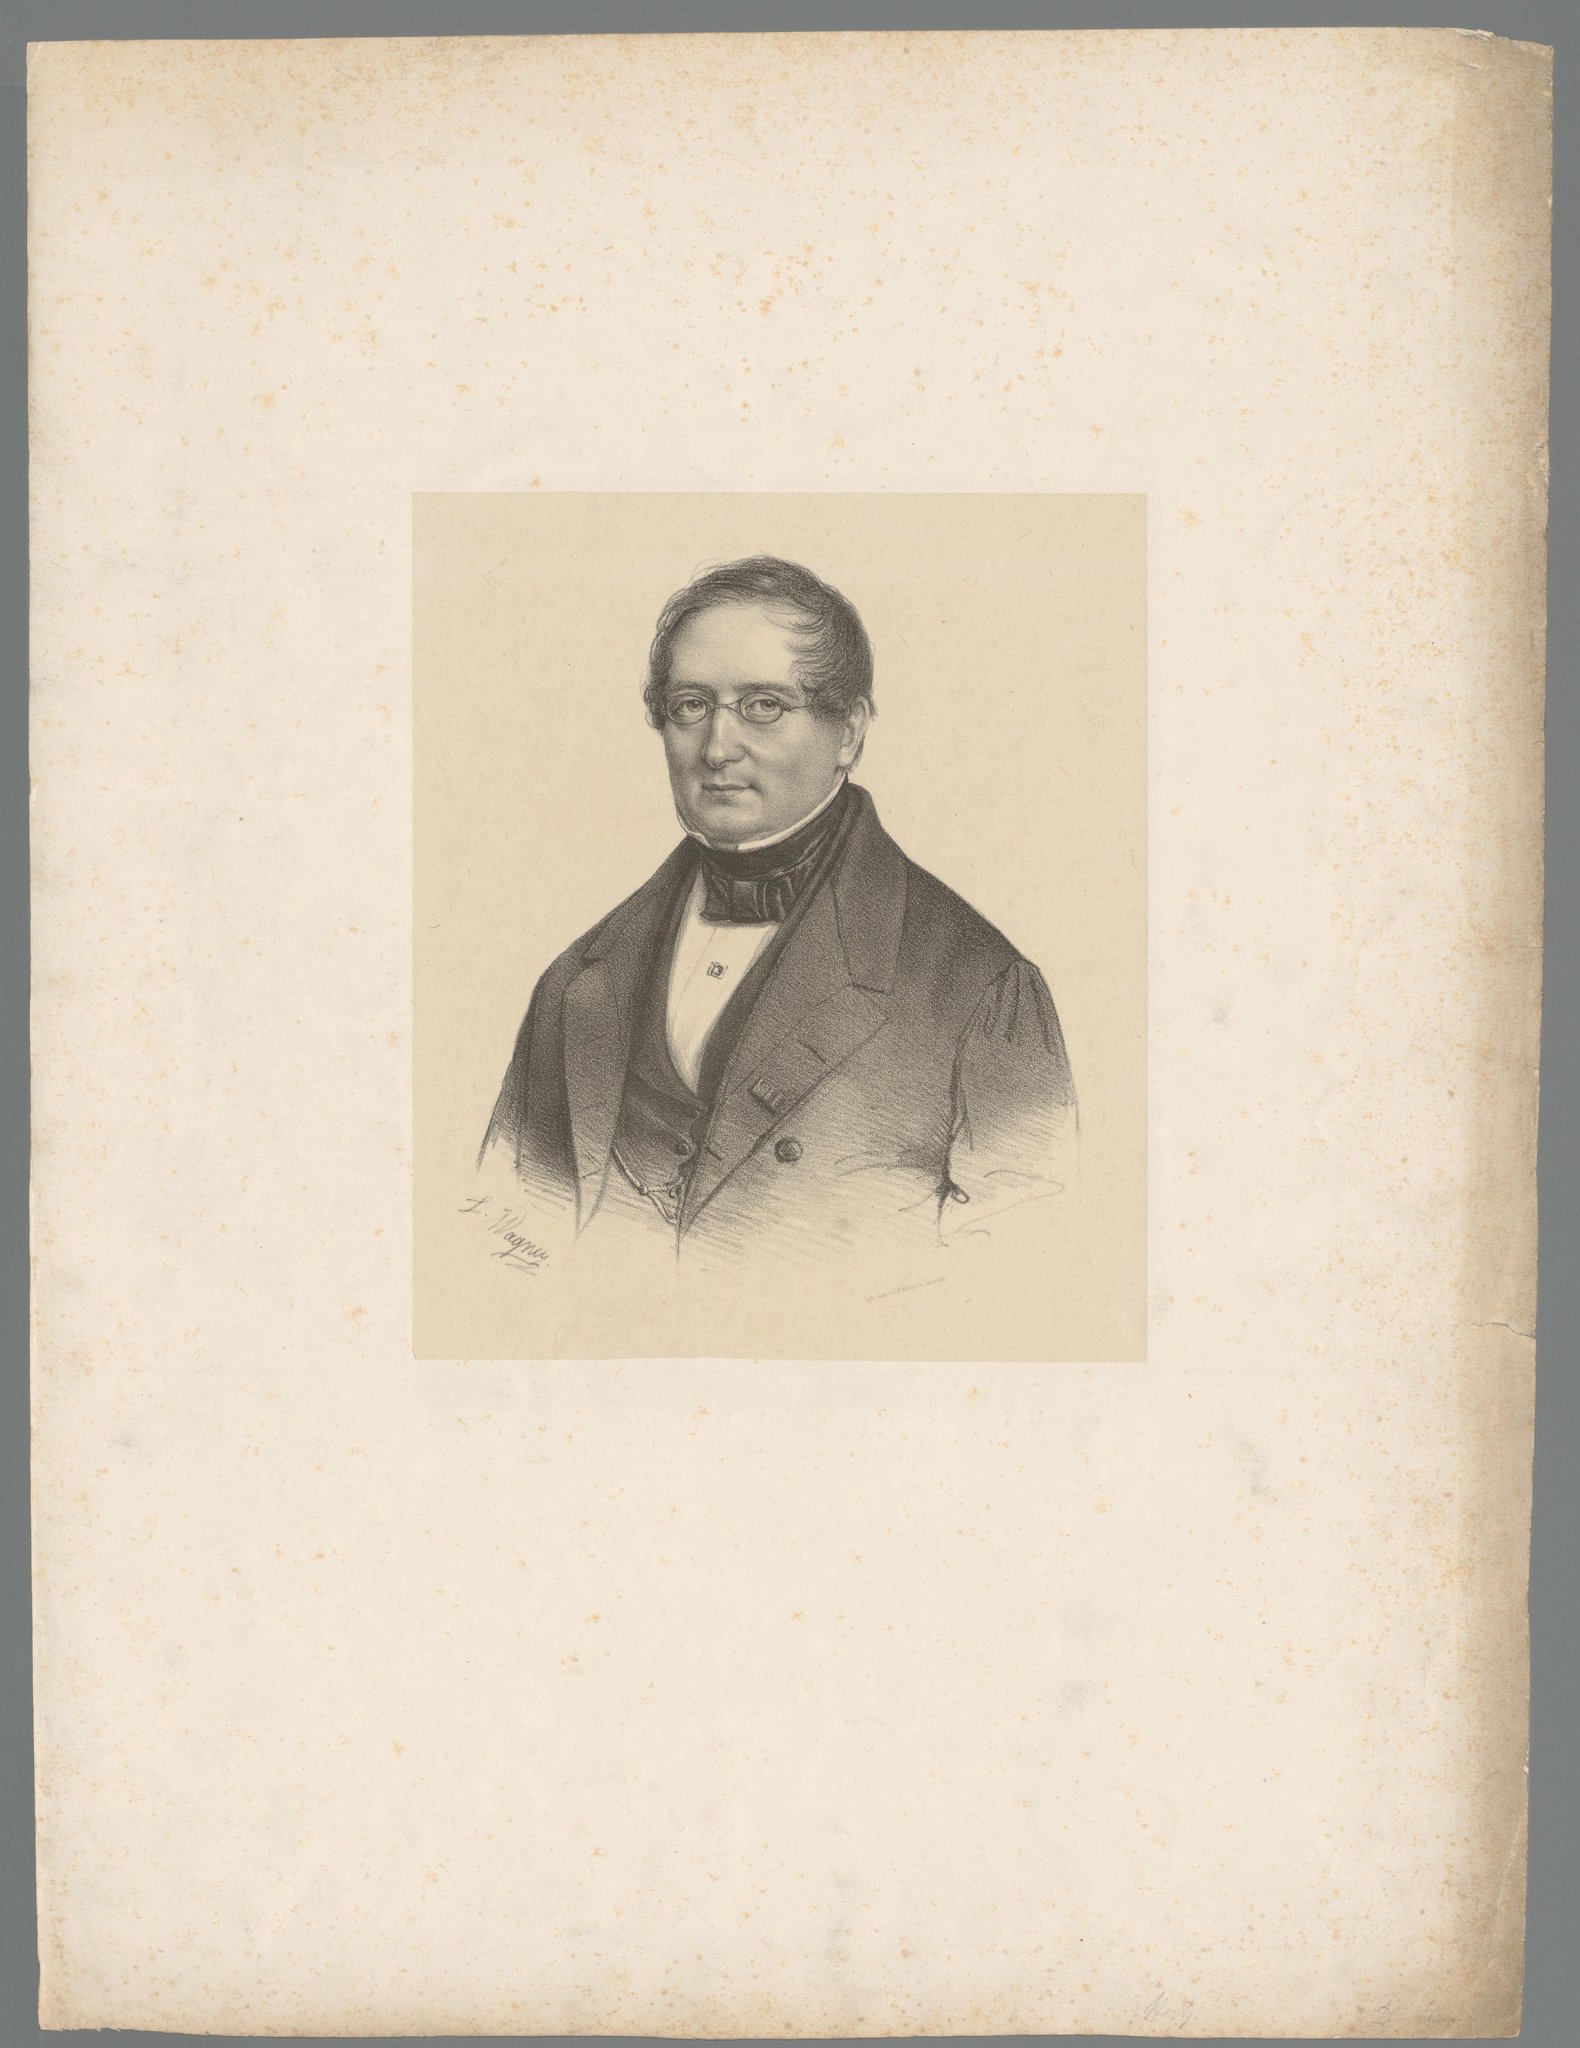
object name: print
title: Portret van een onbekende man, mogelijk Hertz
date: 1790-1850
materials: paper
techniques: lithograph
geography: karlsruhe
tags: eyeglasses, spectacles, adult man, historical persons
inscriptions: collector's mark: Lugt 2228